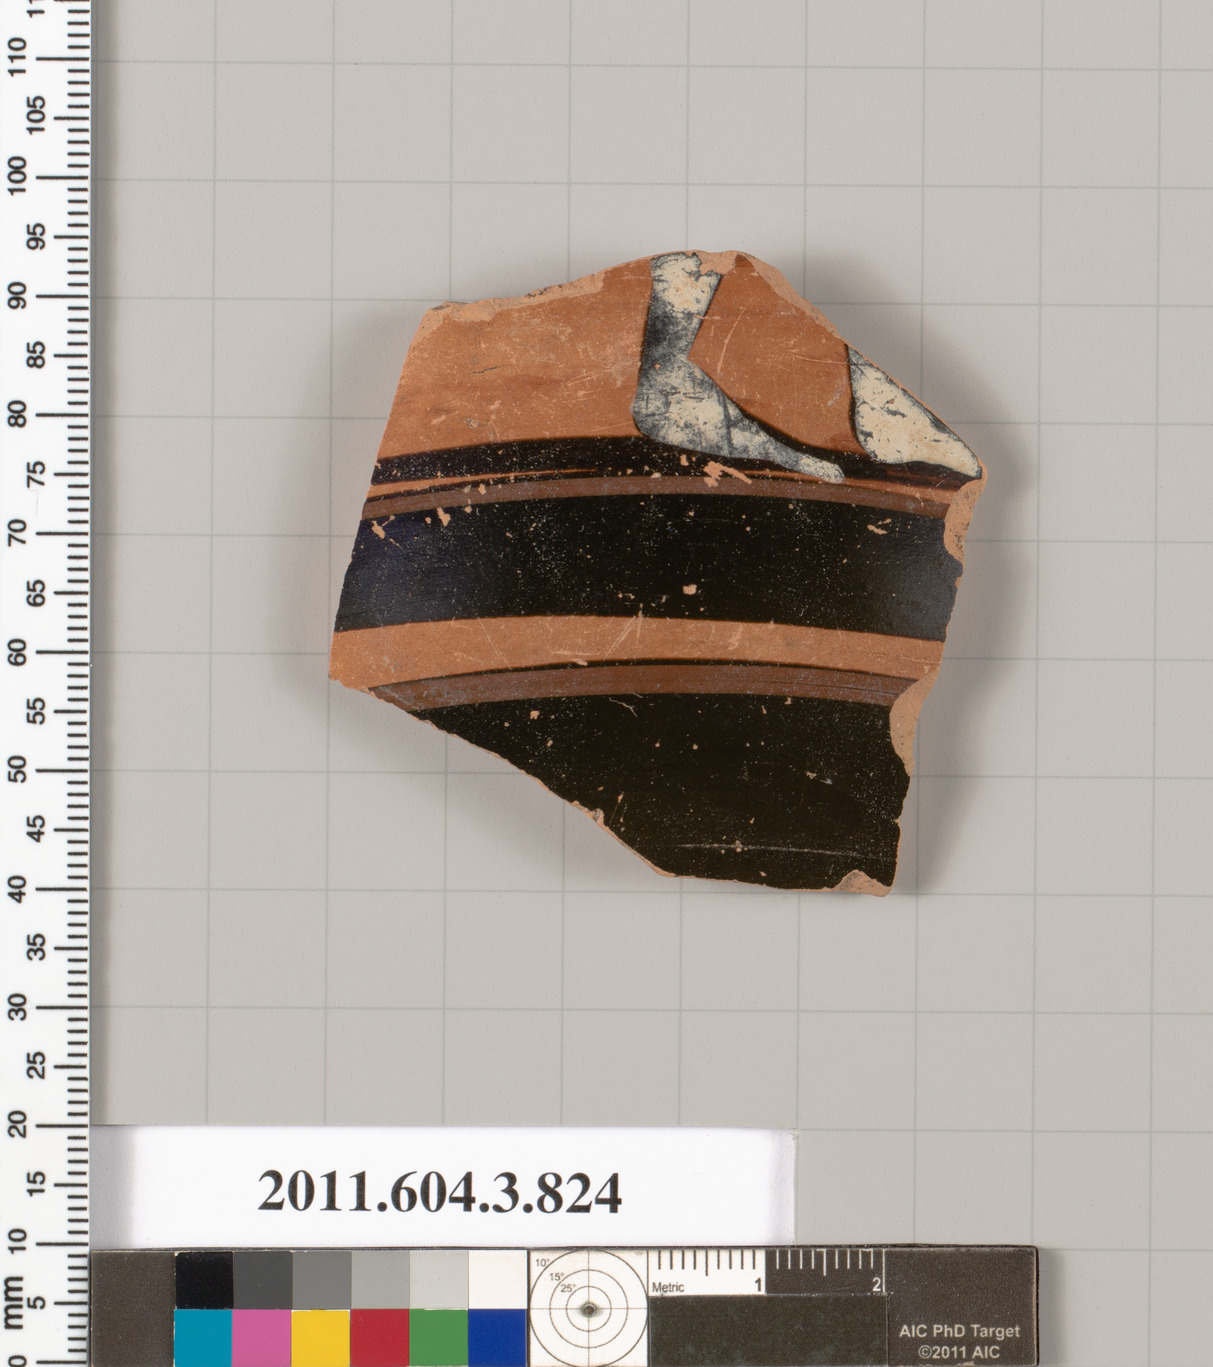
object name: lekythos fragment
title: Terracotta fragment of a lekythos (oil flask)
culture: greek, attic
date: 550-526 BCE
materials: terracotta